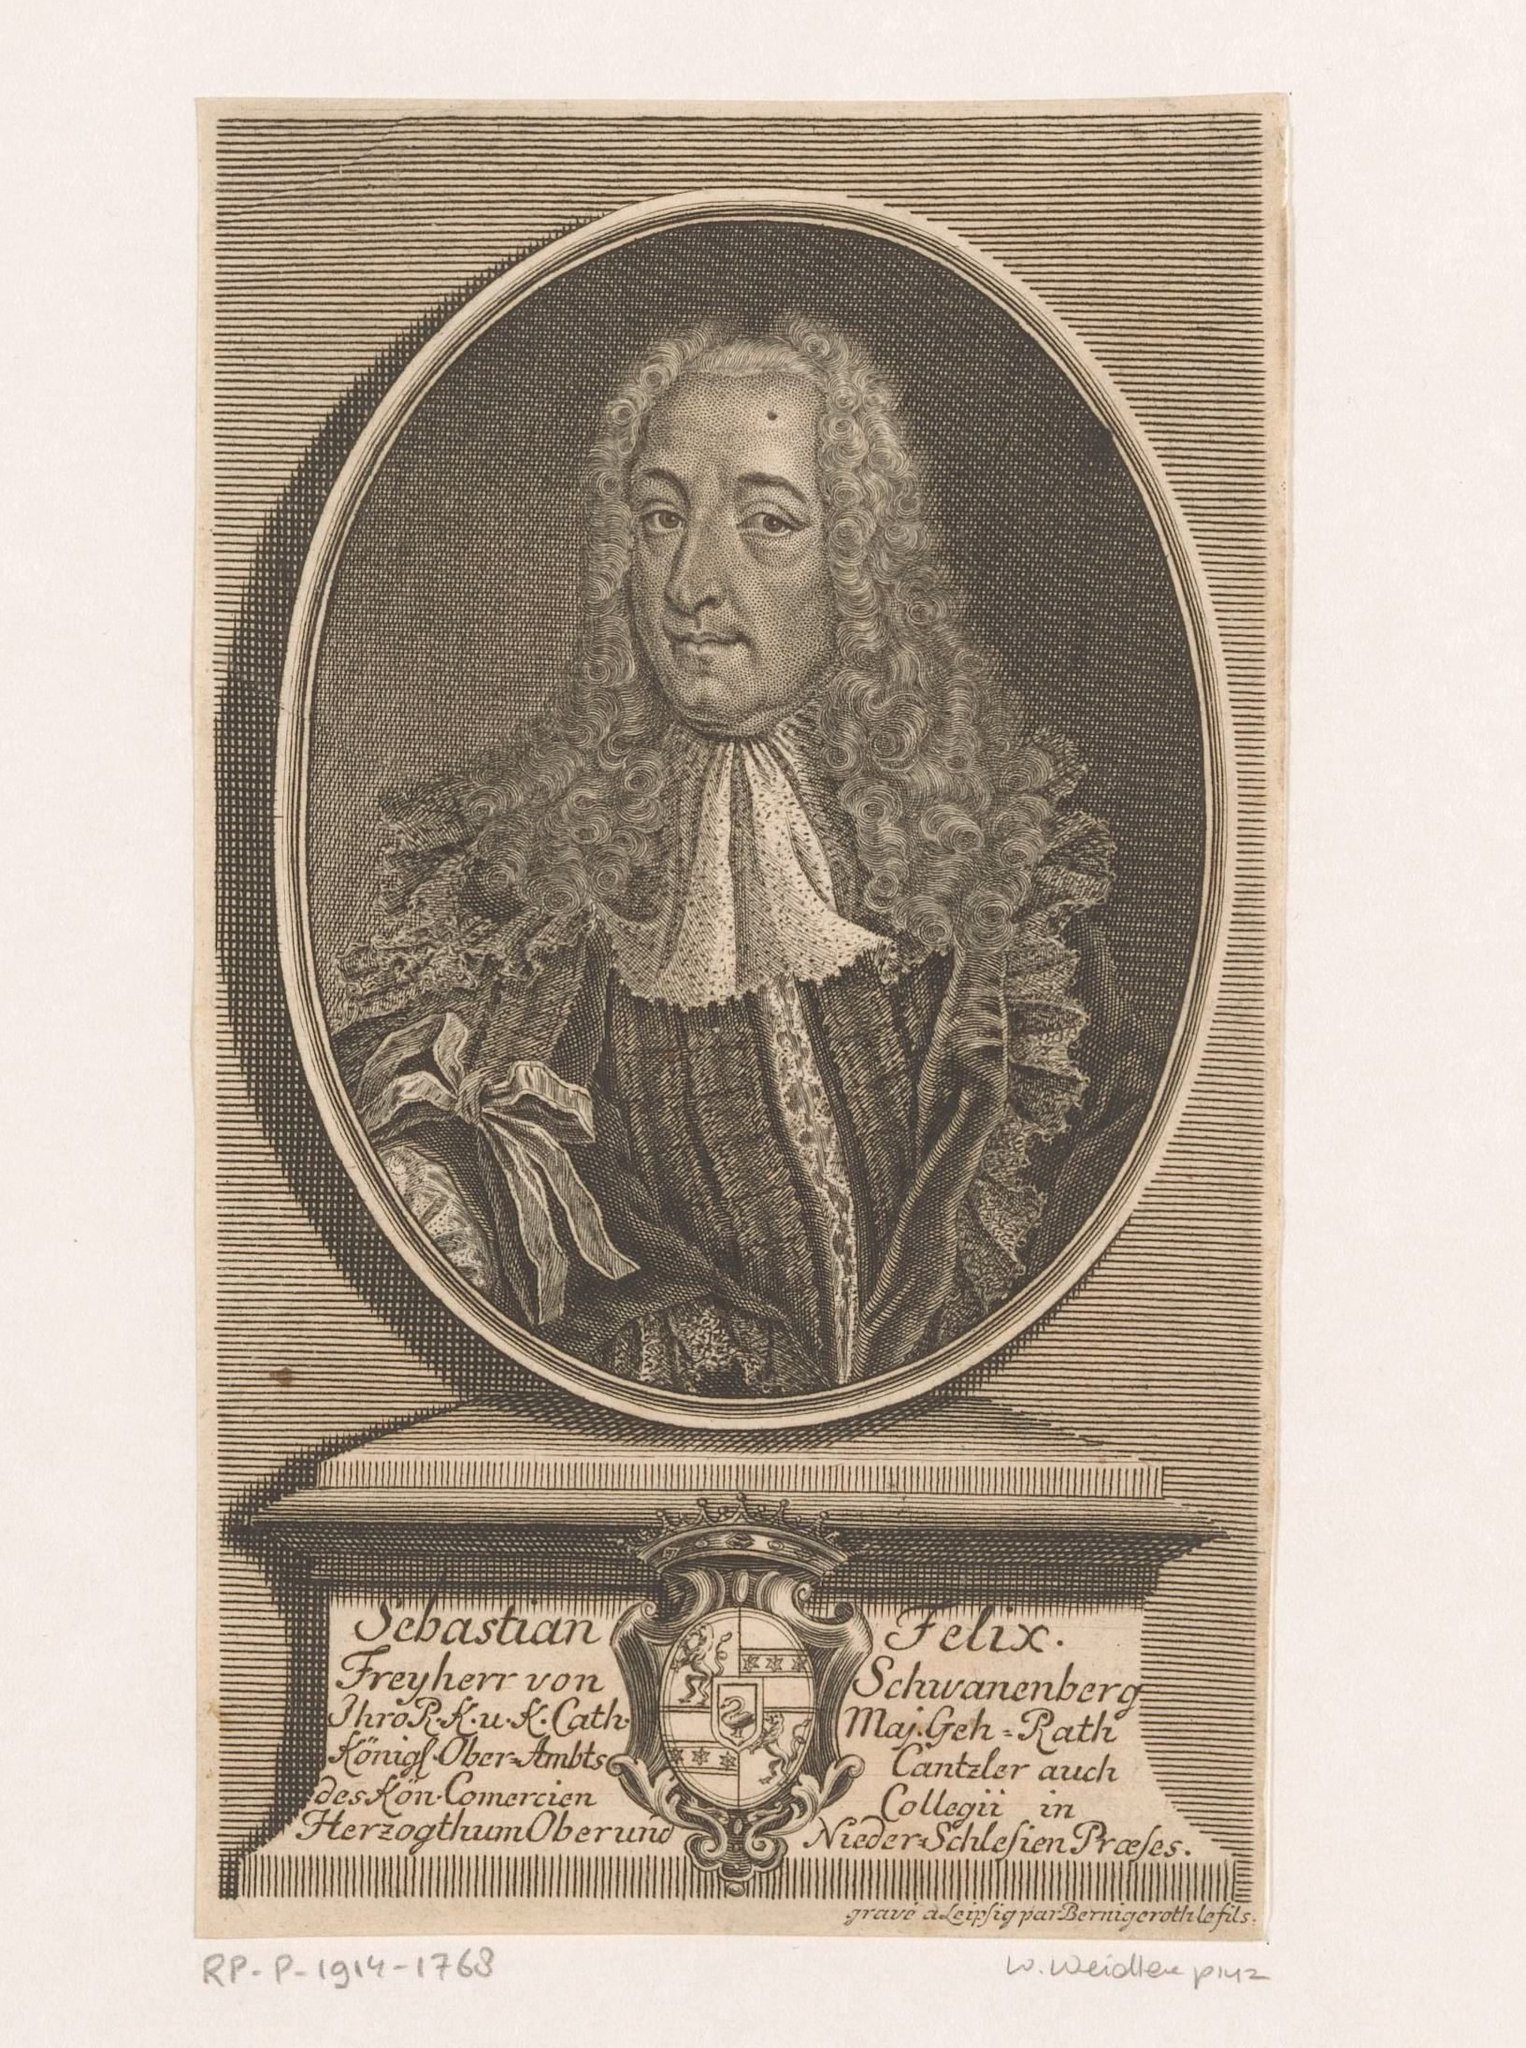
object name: print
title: Portret van Sebastian Felix, Freiherr von Schwanenberg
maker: johann martin bernigeroth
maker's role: print maker, publisher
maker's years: 1713-1767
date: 1736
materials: paper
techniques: engraving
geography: leipzig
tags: historical persons, armorial bearing, heraldry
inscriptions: collector's mark: Lugt 2228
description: Prent ook gebruikt in: Die Neue Europäische Fama, Welche den gegenwärtigen Zustand der vornehmsten Höfe entdecket. dl. 18. Leipzig: Gleditsch, 1736.